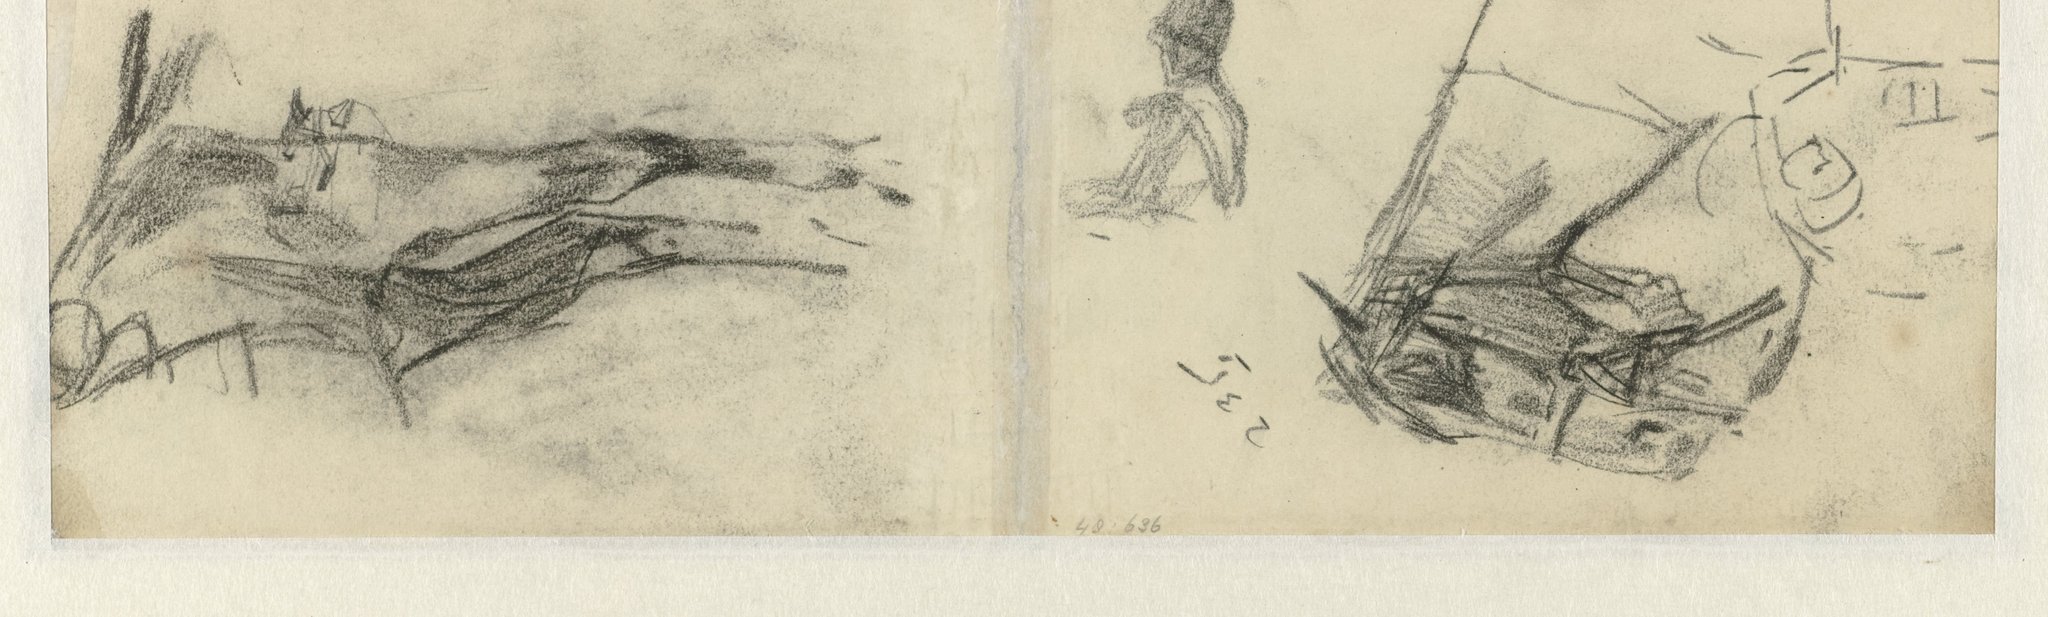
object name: drawing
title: Detailstudies van een paard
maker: george hendrik breitner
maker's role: draughtsman, painter, print maker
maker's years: 1857-1923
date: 1867-1923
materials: chalk, paper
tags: land forces (+ cavalry, horsemen), horse